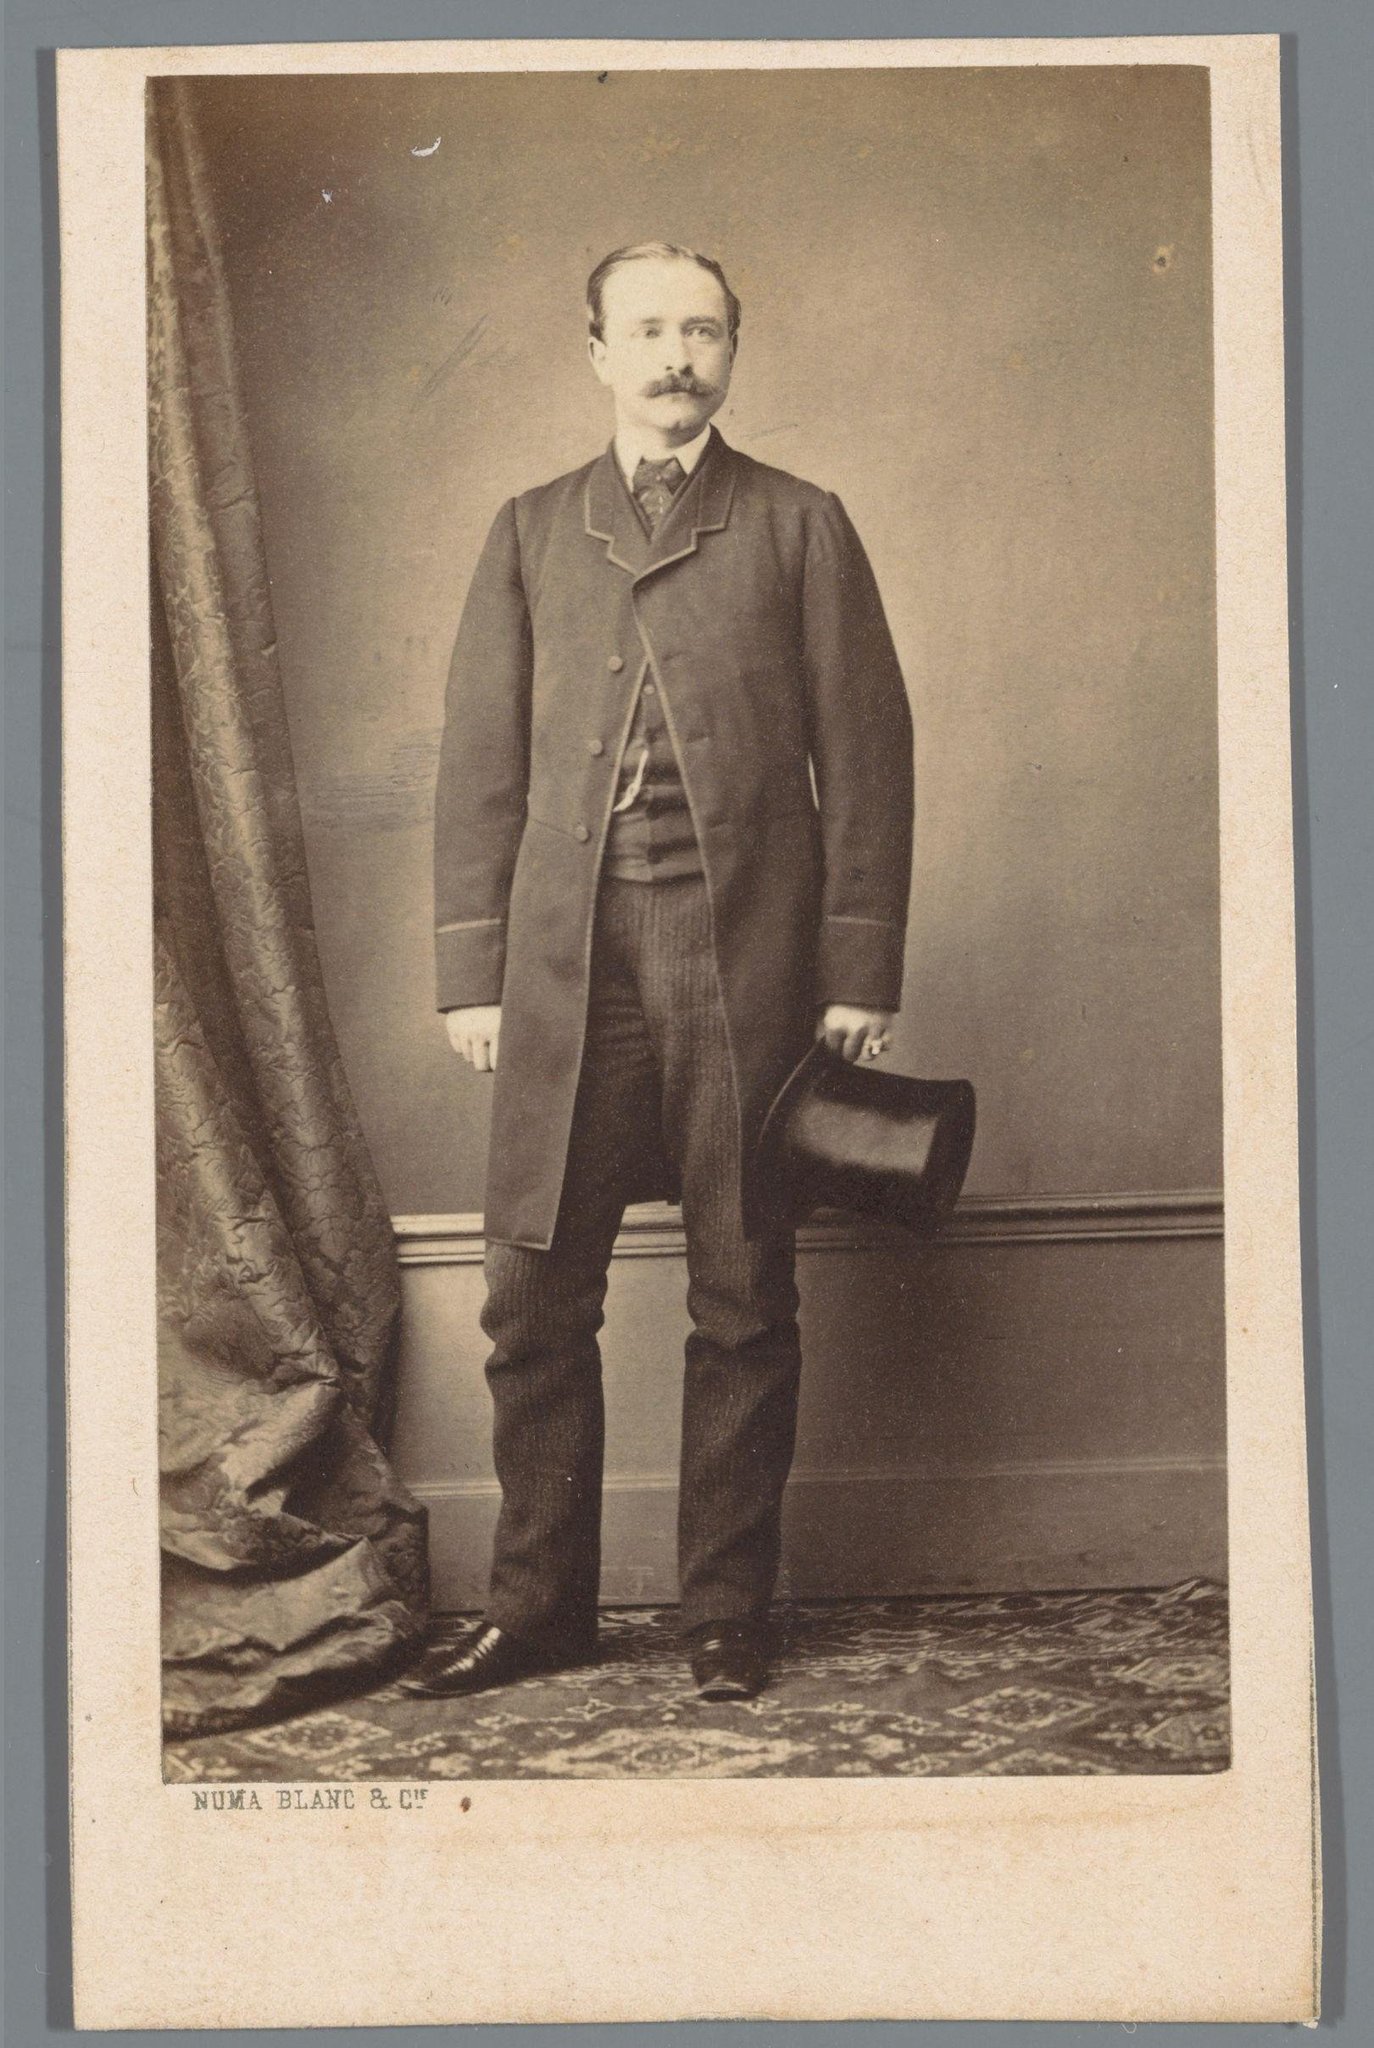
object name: photograph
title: Portret van een onbekende man met een hoed in zijn hand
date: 1850-1865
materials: cardboard, paper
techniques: albumen print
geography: paris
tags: adult man, historical persons, head-gear: top hat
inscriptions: inscription: ‘NUMA BLANC & Cie/ PHOTOGRAPHES./ 29, Boulevart des Italiens./ PARIS’